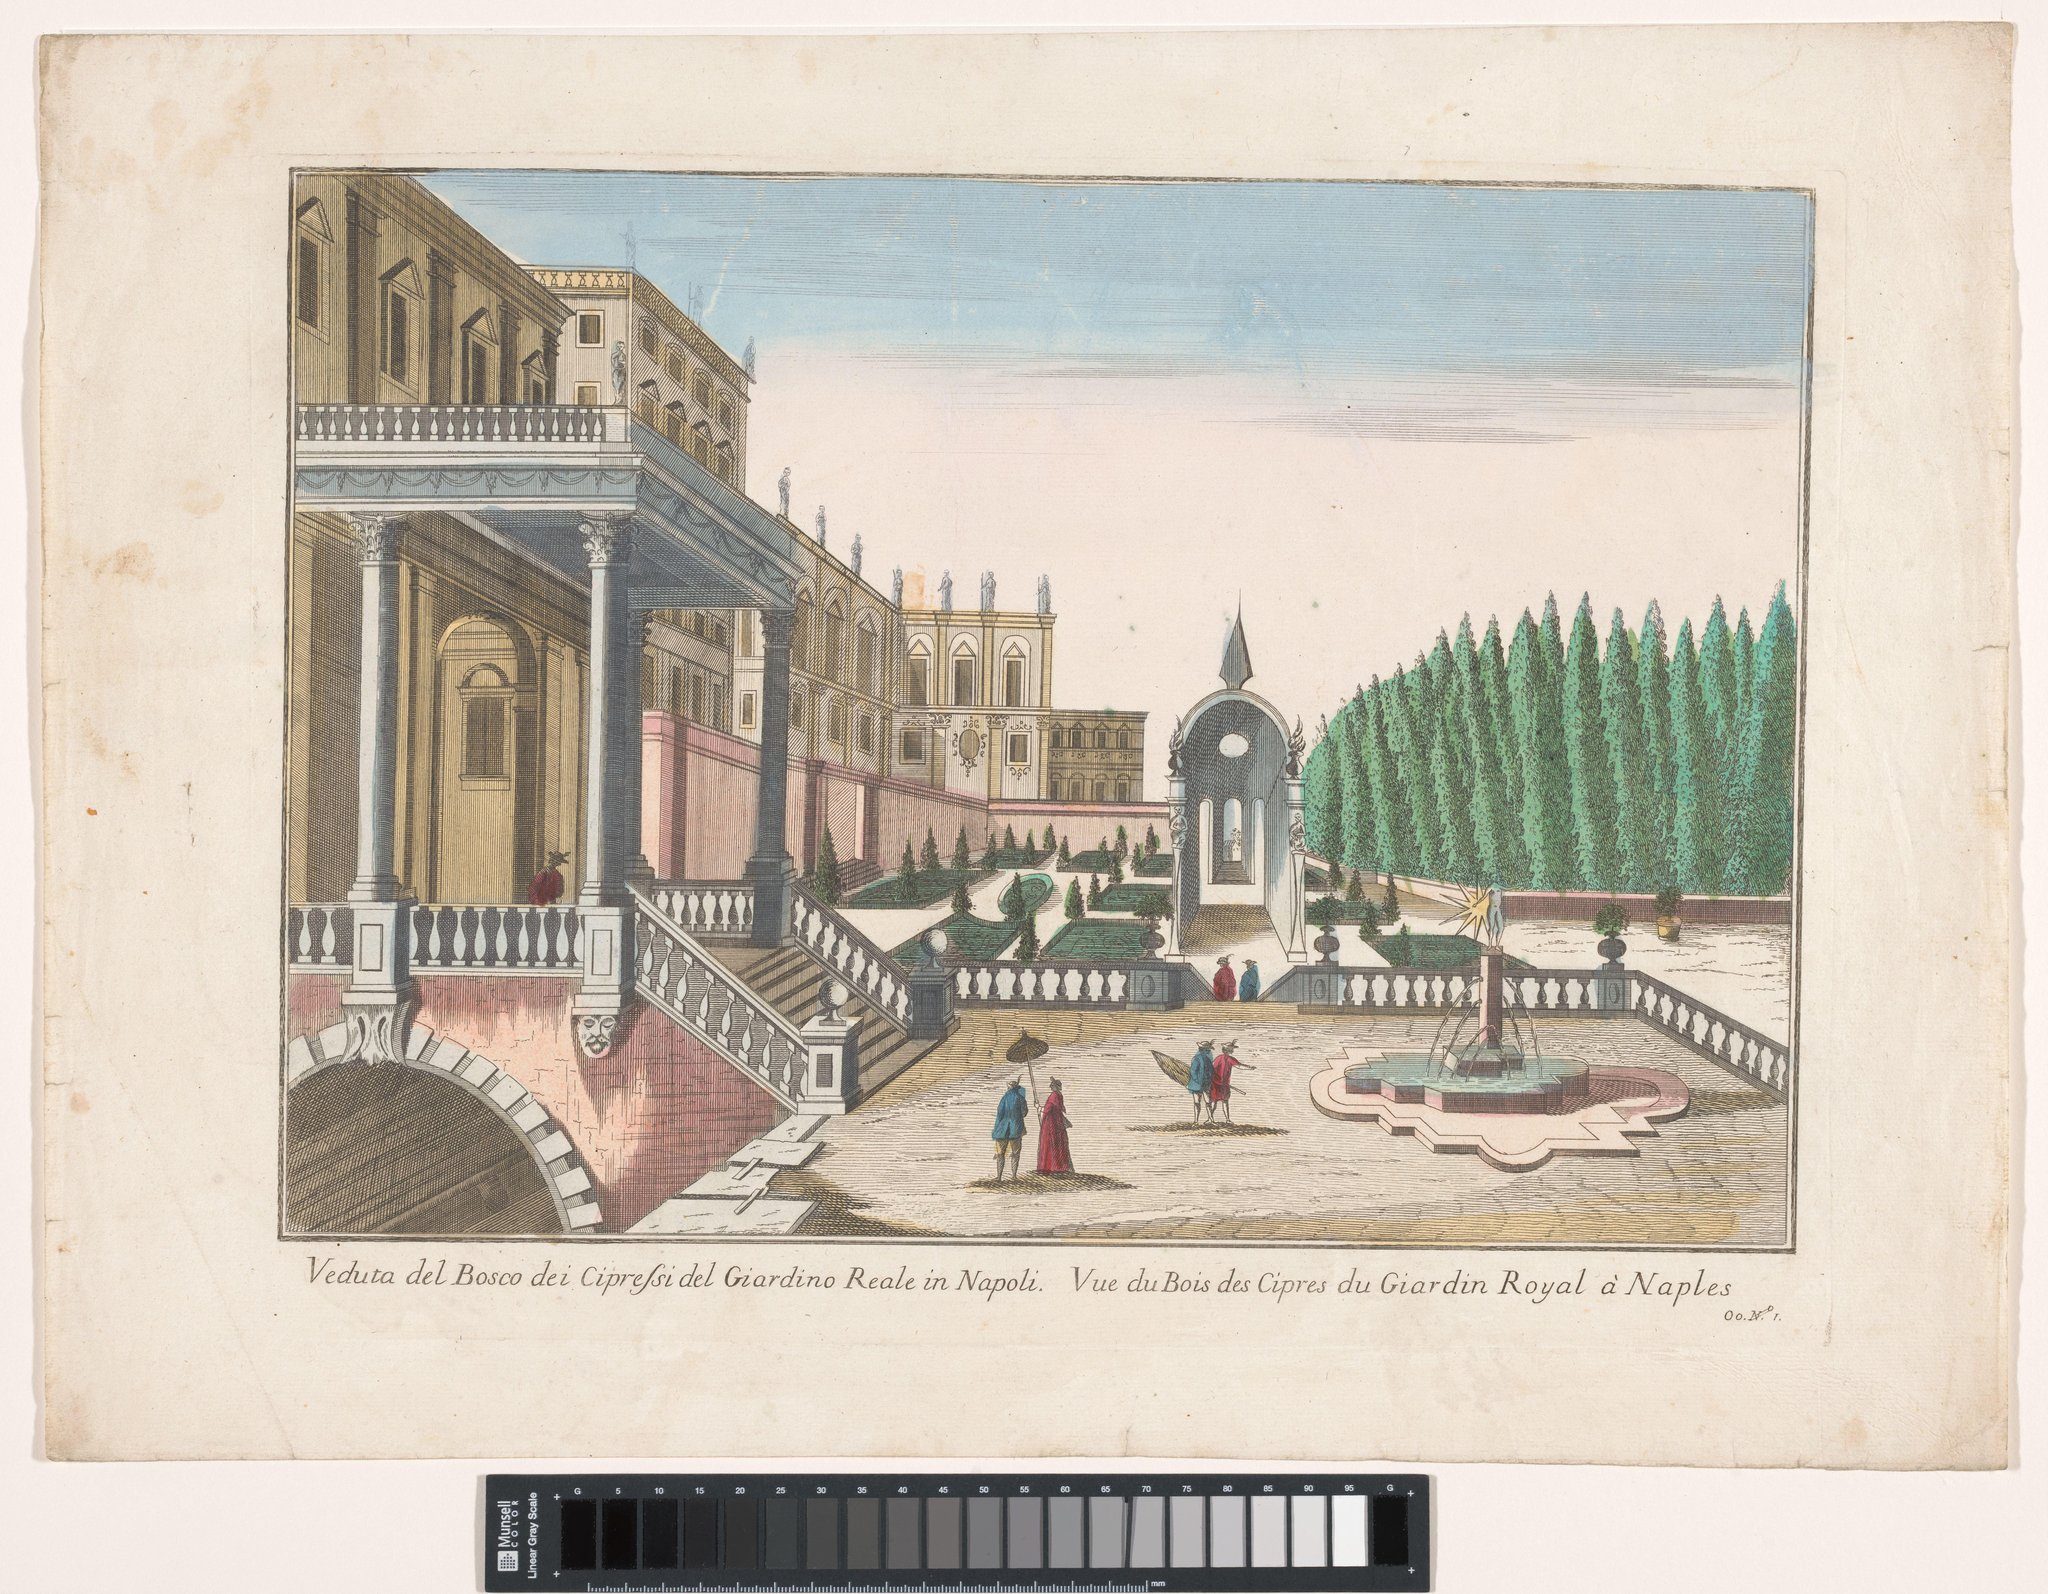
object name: print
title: Gezicht op een tuin en een koninklijk paleis te Napels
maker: Anonymous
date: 1700-1799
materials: paper, watercolor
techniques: brush, etching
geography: italy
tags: trees: cypress, garden, garden fountain, ornamental plants, palace, naples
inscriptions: collector's mark: Lugt 2228